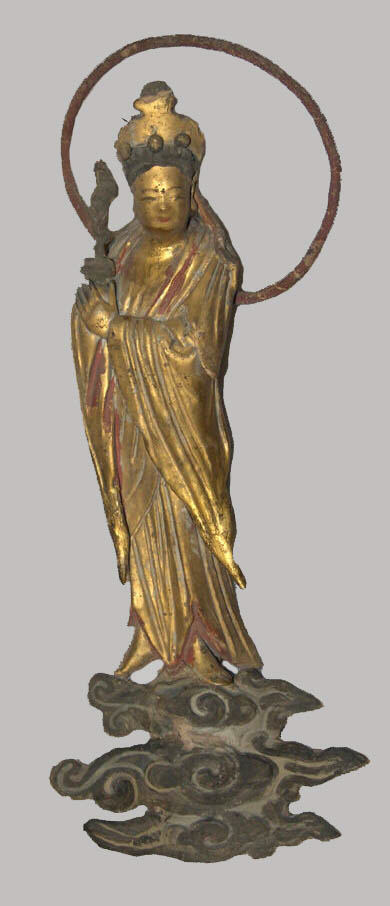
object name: figure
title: Figure of Attendant Deity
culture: chinese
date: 1368-1644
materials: mud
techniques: gilding, painting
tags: human figures